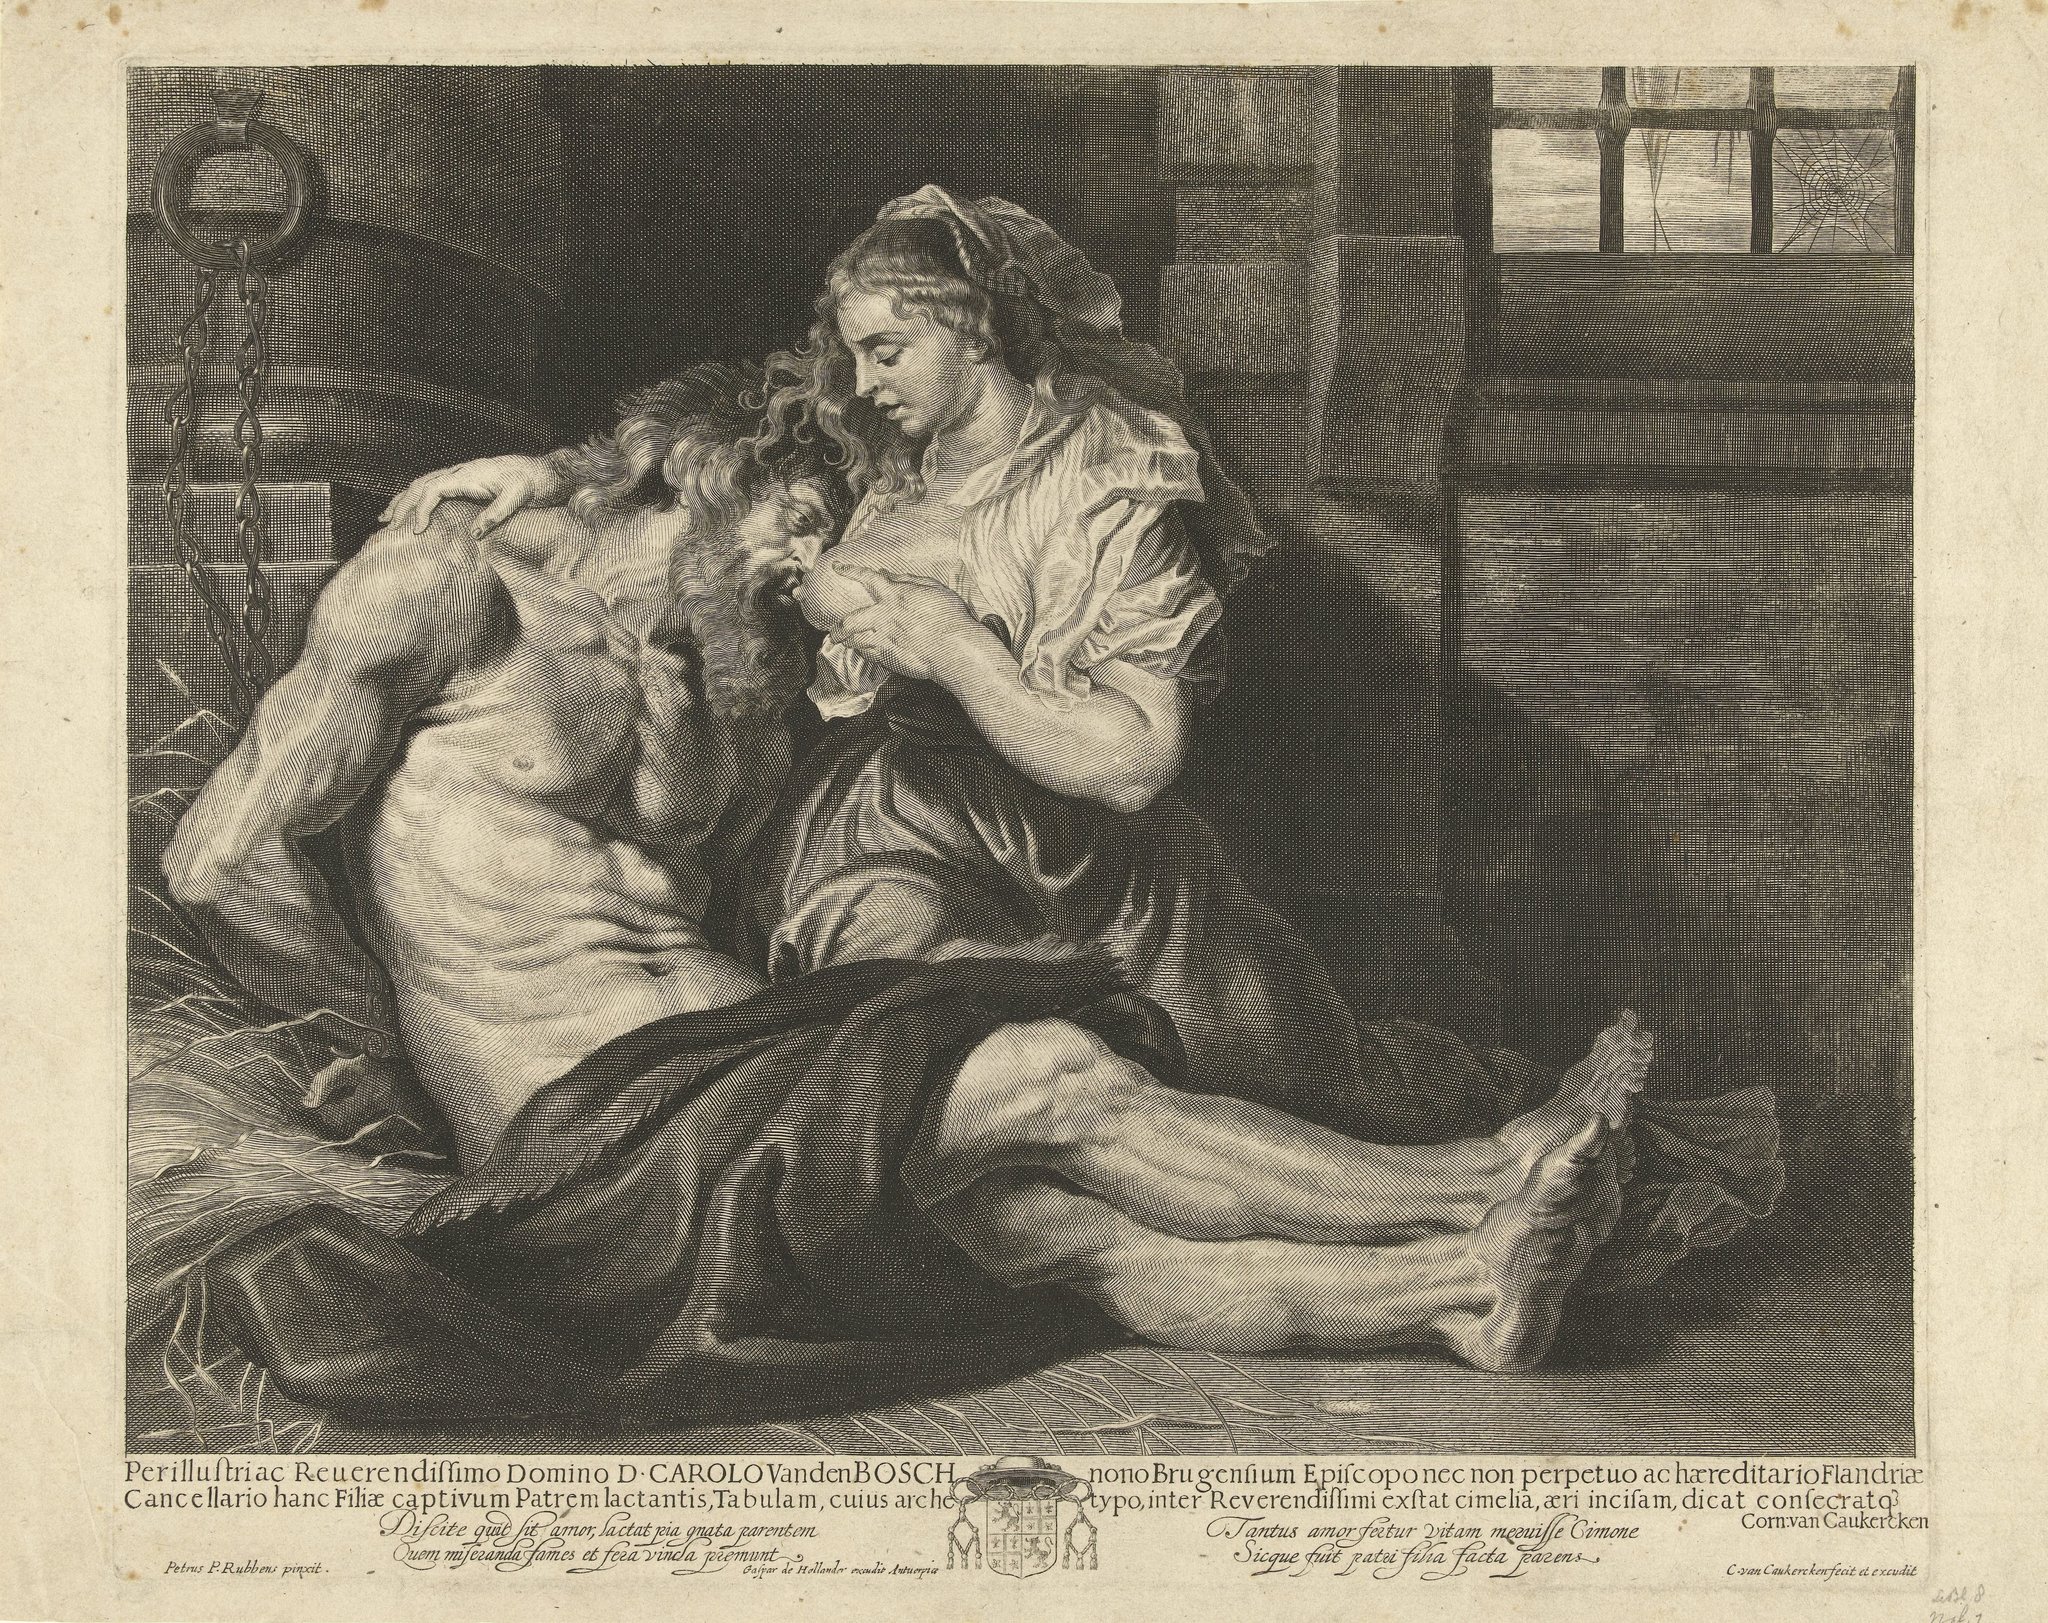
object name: print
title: Cimon en Pero (Caritas Romana)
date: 1640-1660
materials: paper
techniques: engraving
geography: antwerp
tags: pero suckling cimon ('caritas romana')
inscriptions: collector's mark: Lugt 2228, collector's mark: Lugt 240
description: Pero geeft haar vader, die geboeid in de gevangenis zit, de borst. Cimon zit op de grond in het stro een doek om zijn midden geslagen. Rechts een getralied raam.